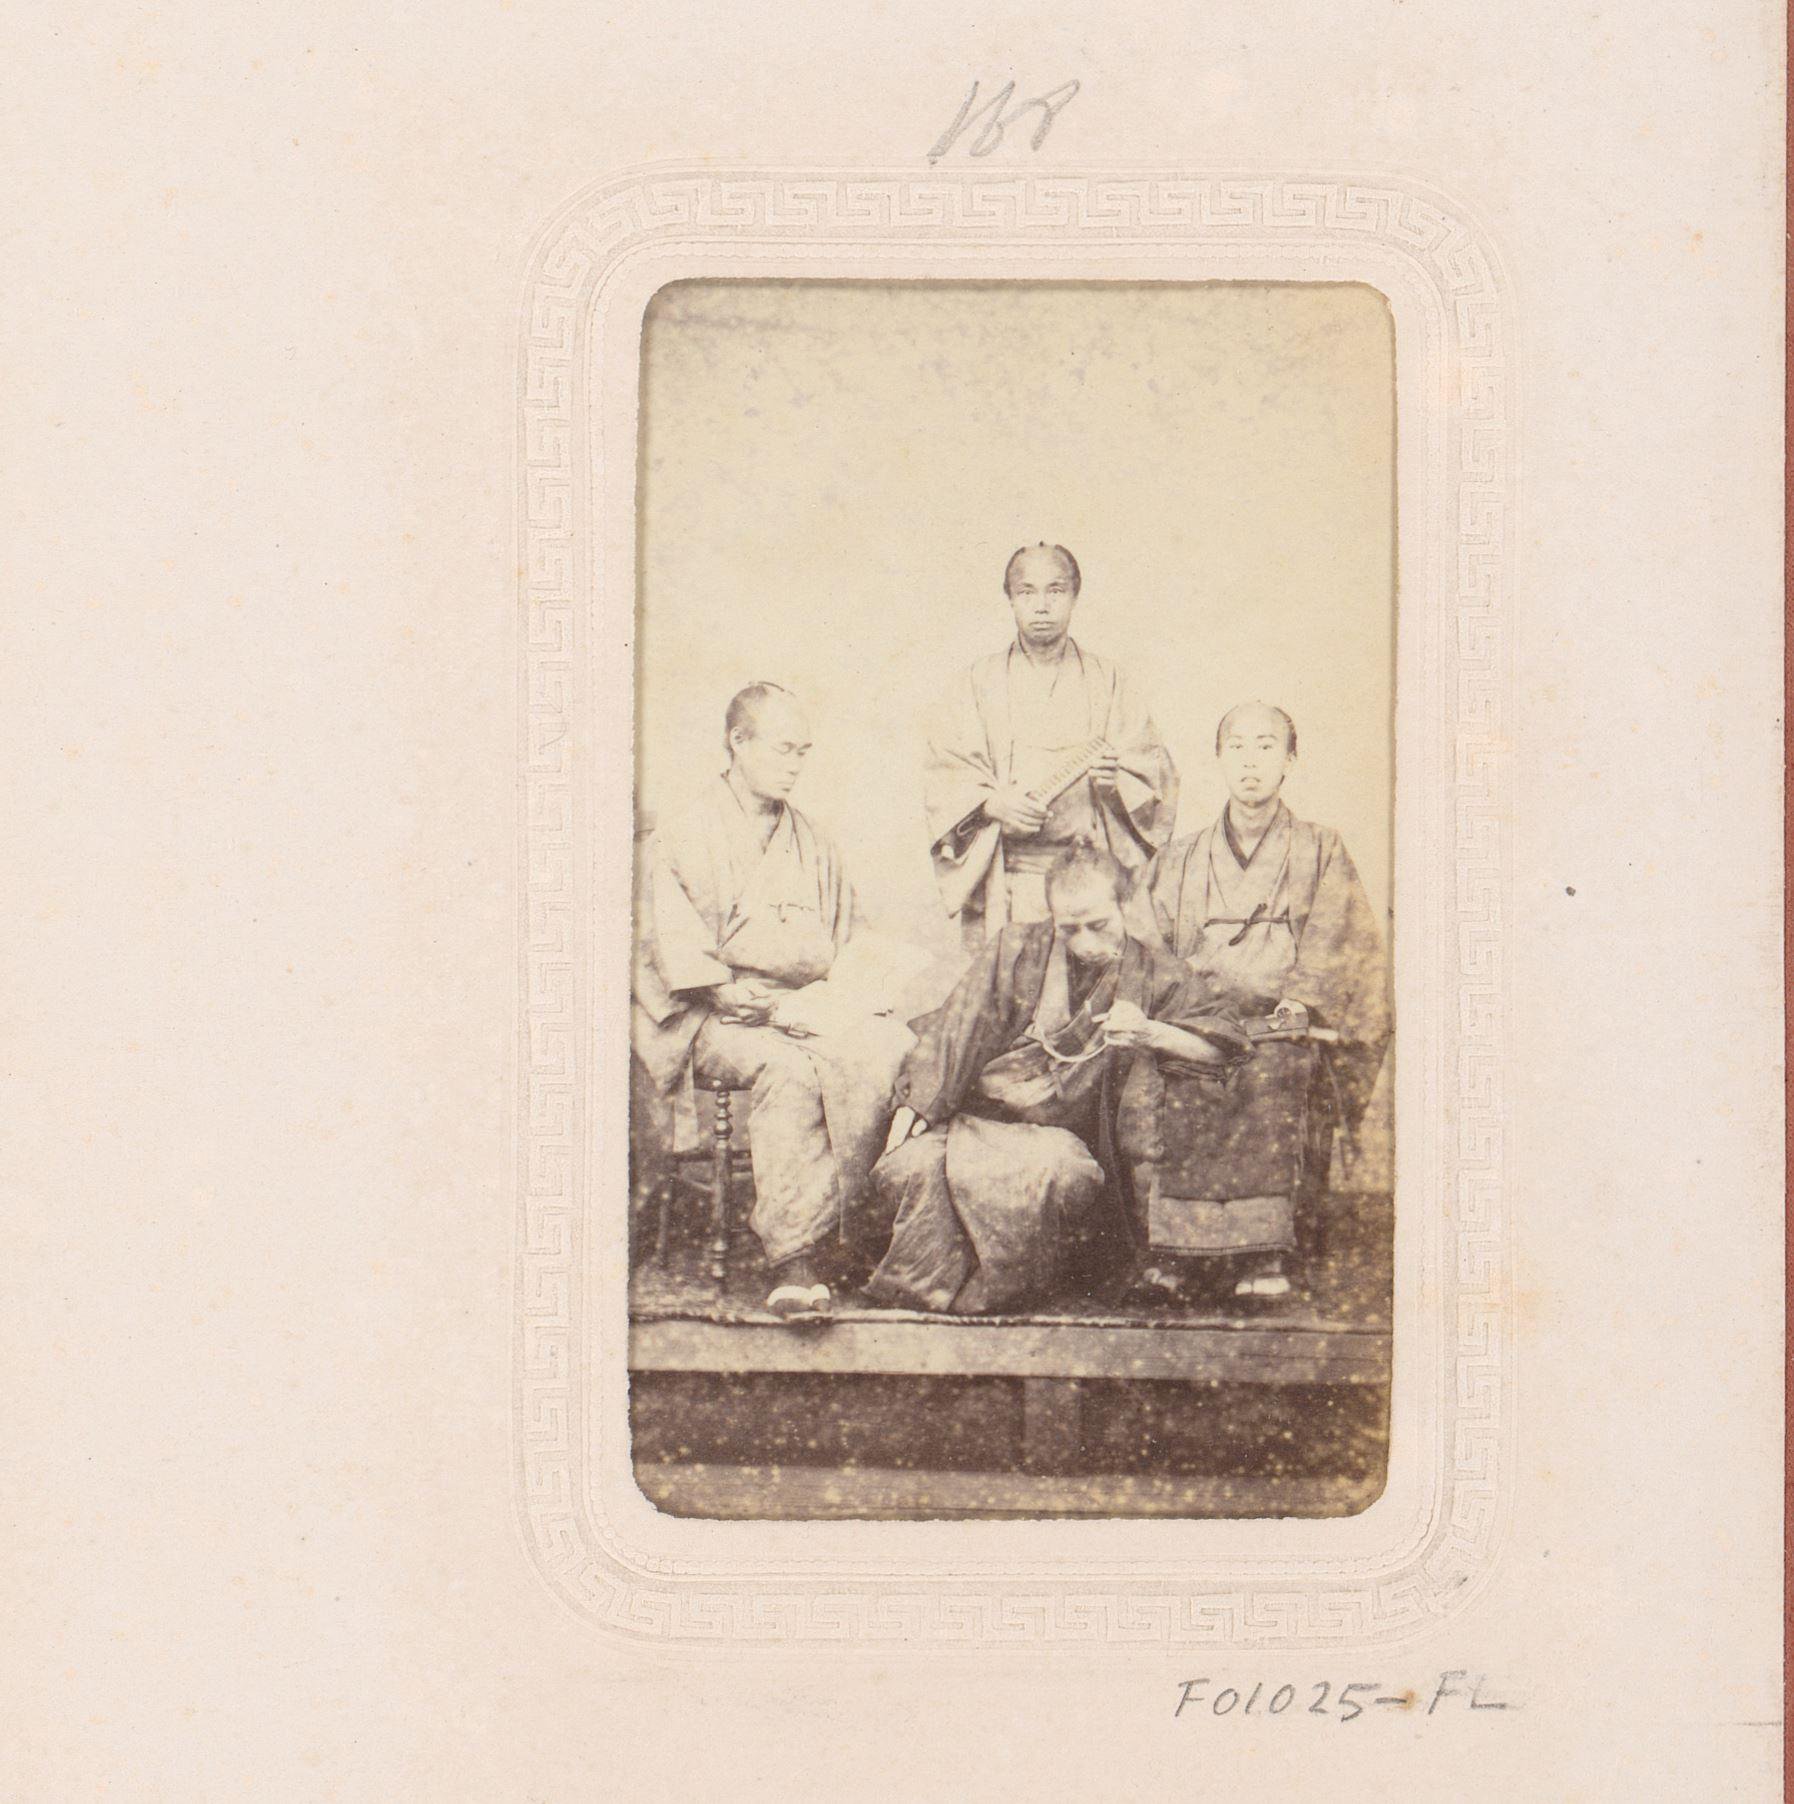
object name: album leaf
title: Portret van Japanse priesters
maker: Anonymous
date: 1850-1880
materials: cardboard, photographic support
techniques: albumen print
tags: priest ~ non-christian religions, anonymous historical persons portrayed in a group, in a group-portrait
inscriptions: number: ‘168’